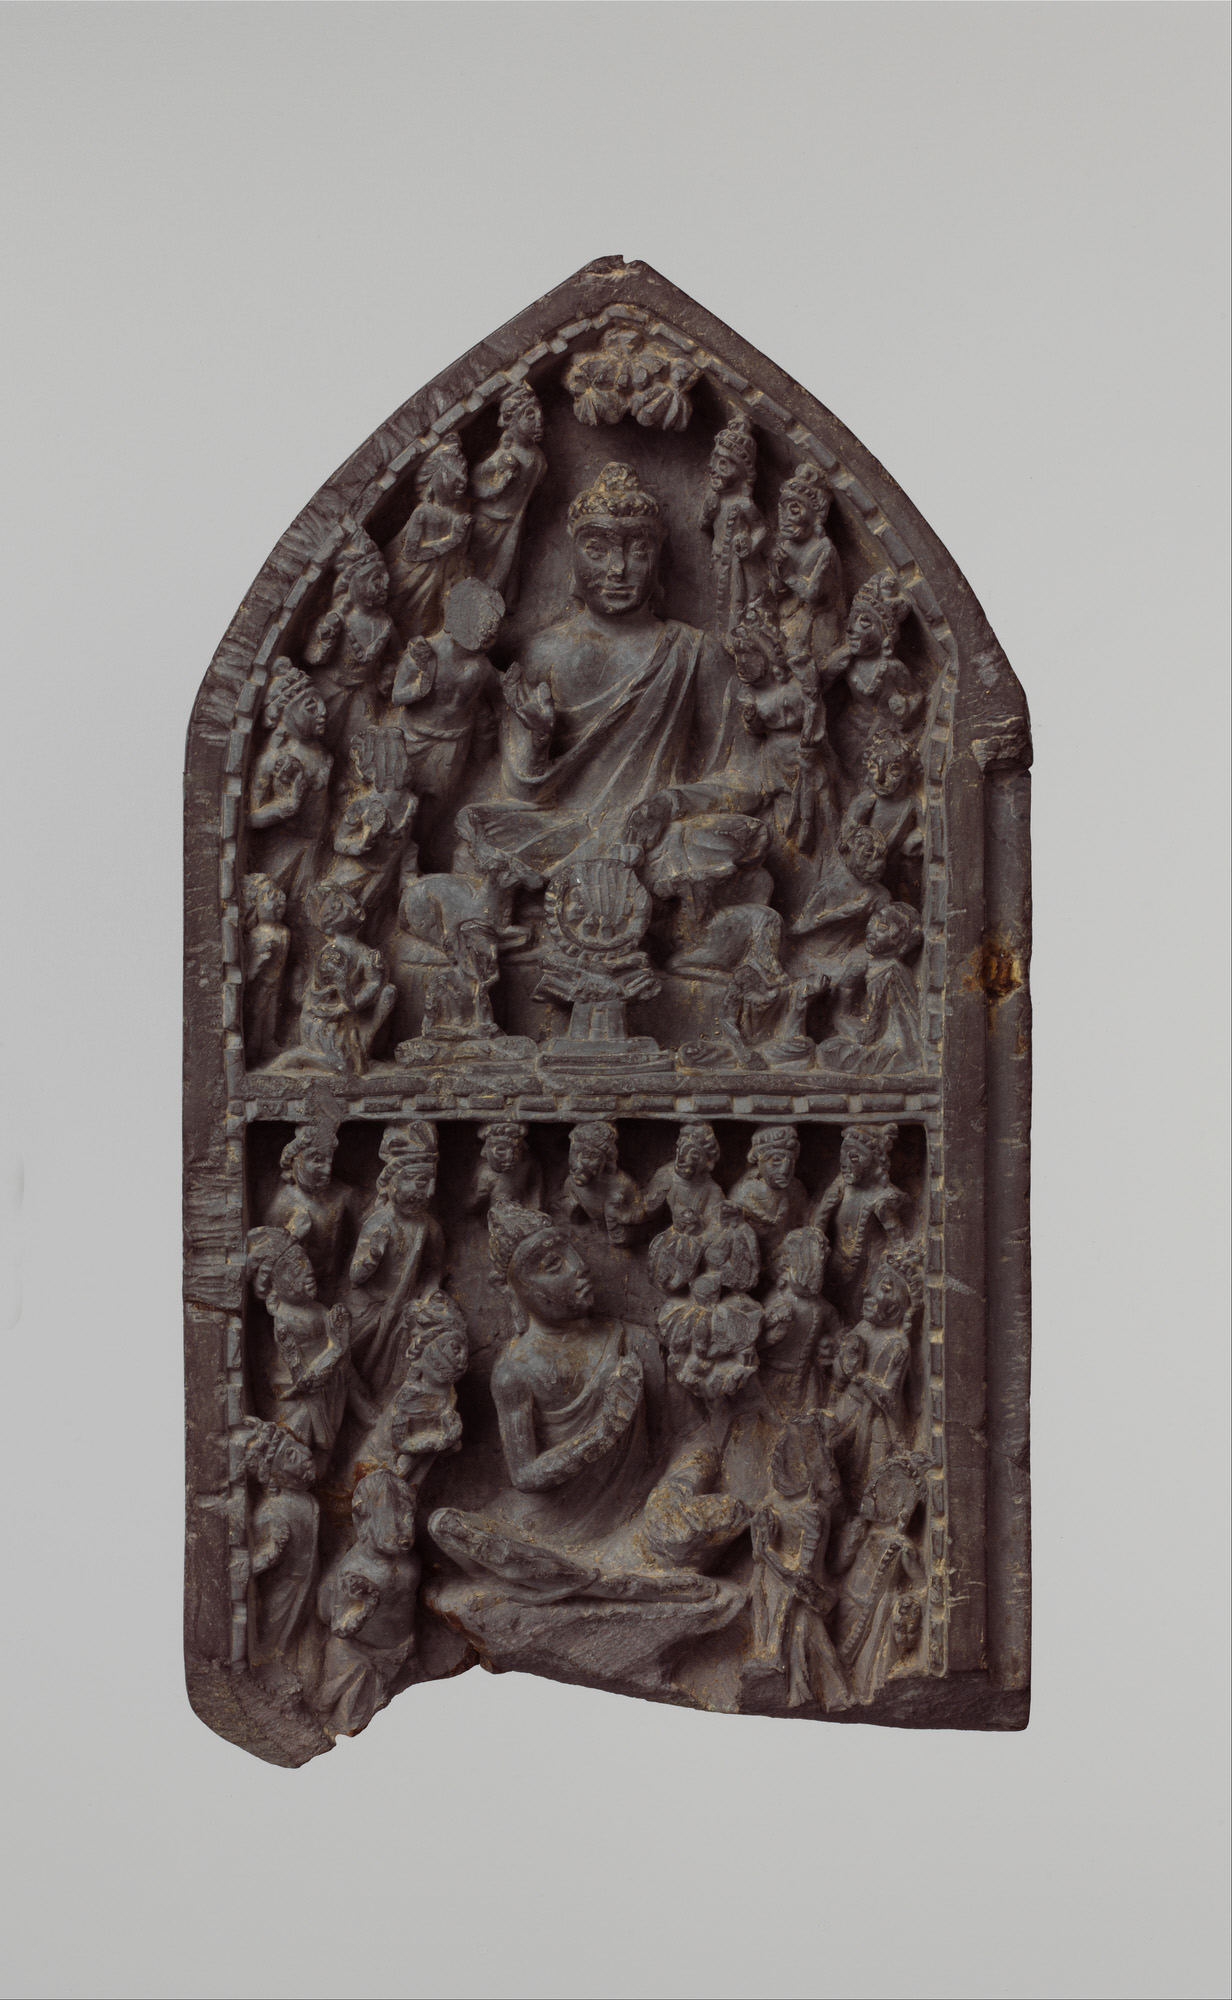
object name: shrine panel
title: Panel of a Portable Shrine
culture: gandhara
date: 401-600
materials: stone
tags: gandhara,men,buddhism,buddha